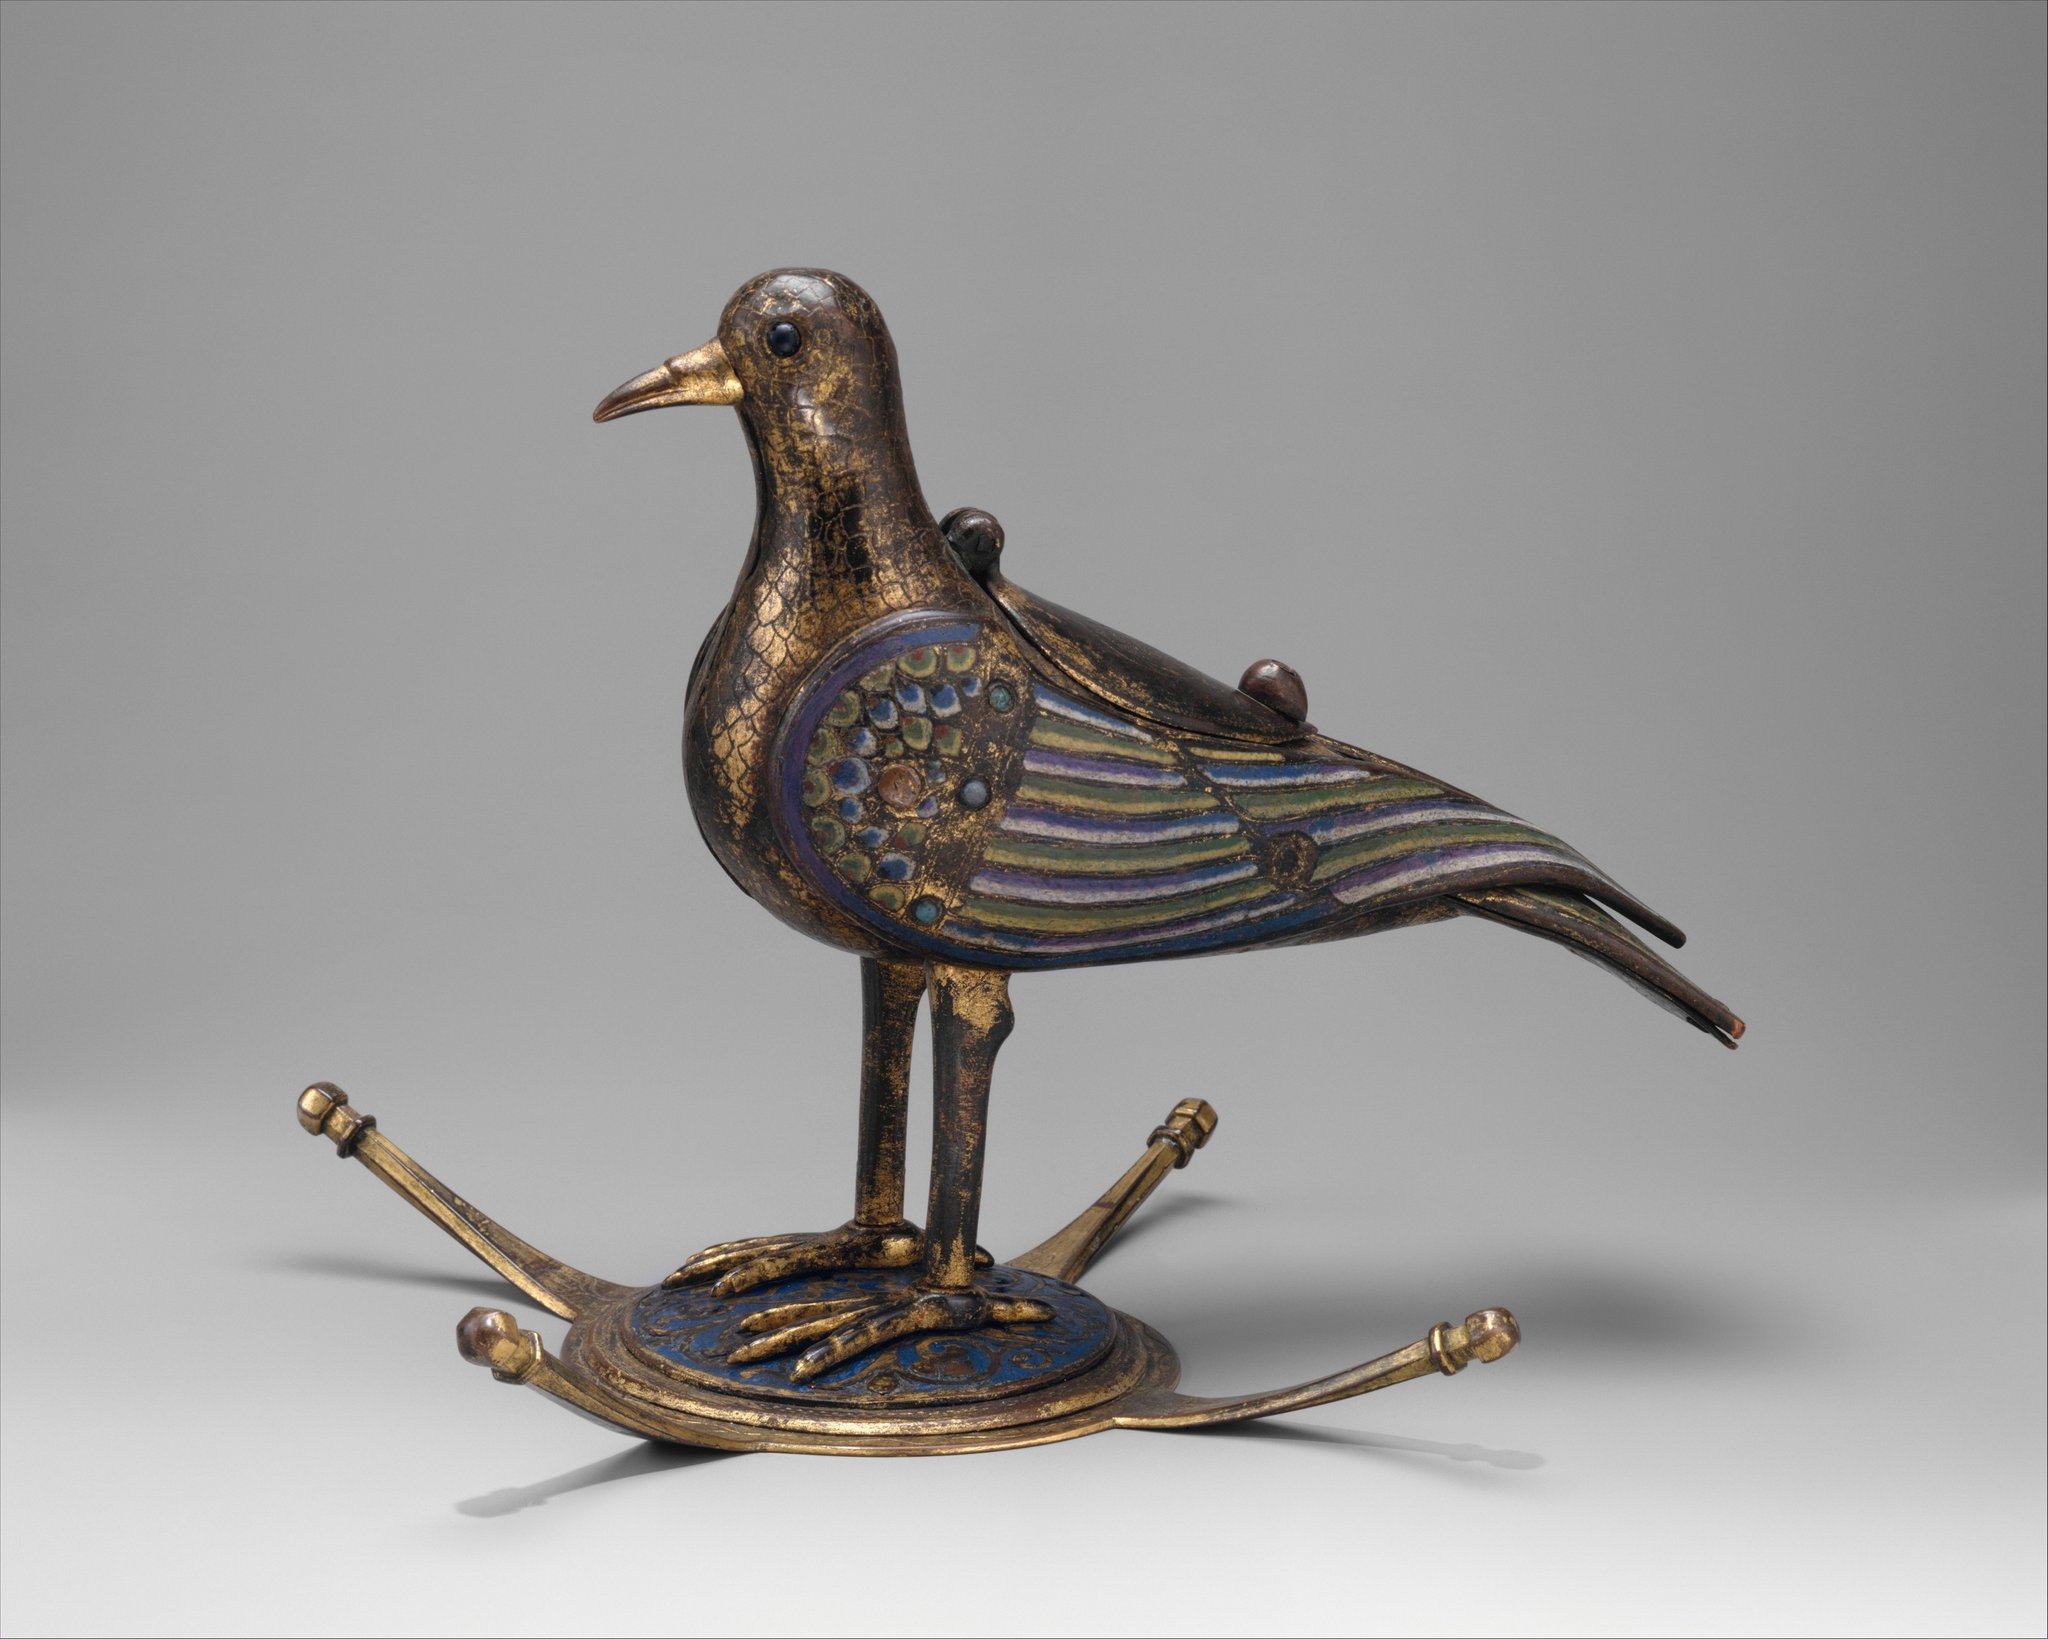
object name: dove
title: Eucharistic Dove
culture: french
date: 1215-1235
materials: enamel, gilt copper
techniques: enamel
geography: france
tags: doves